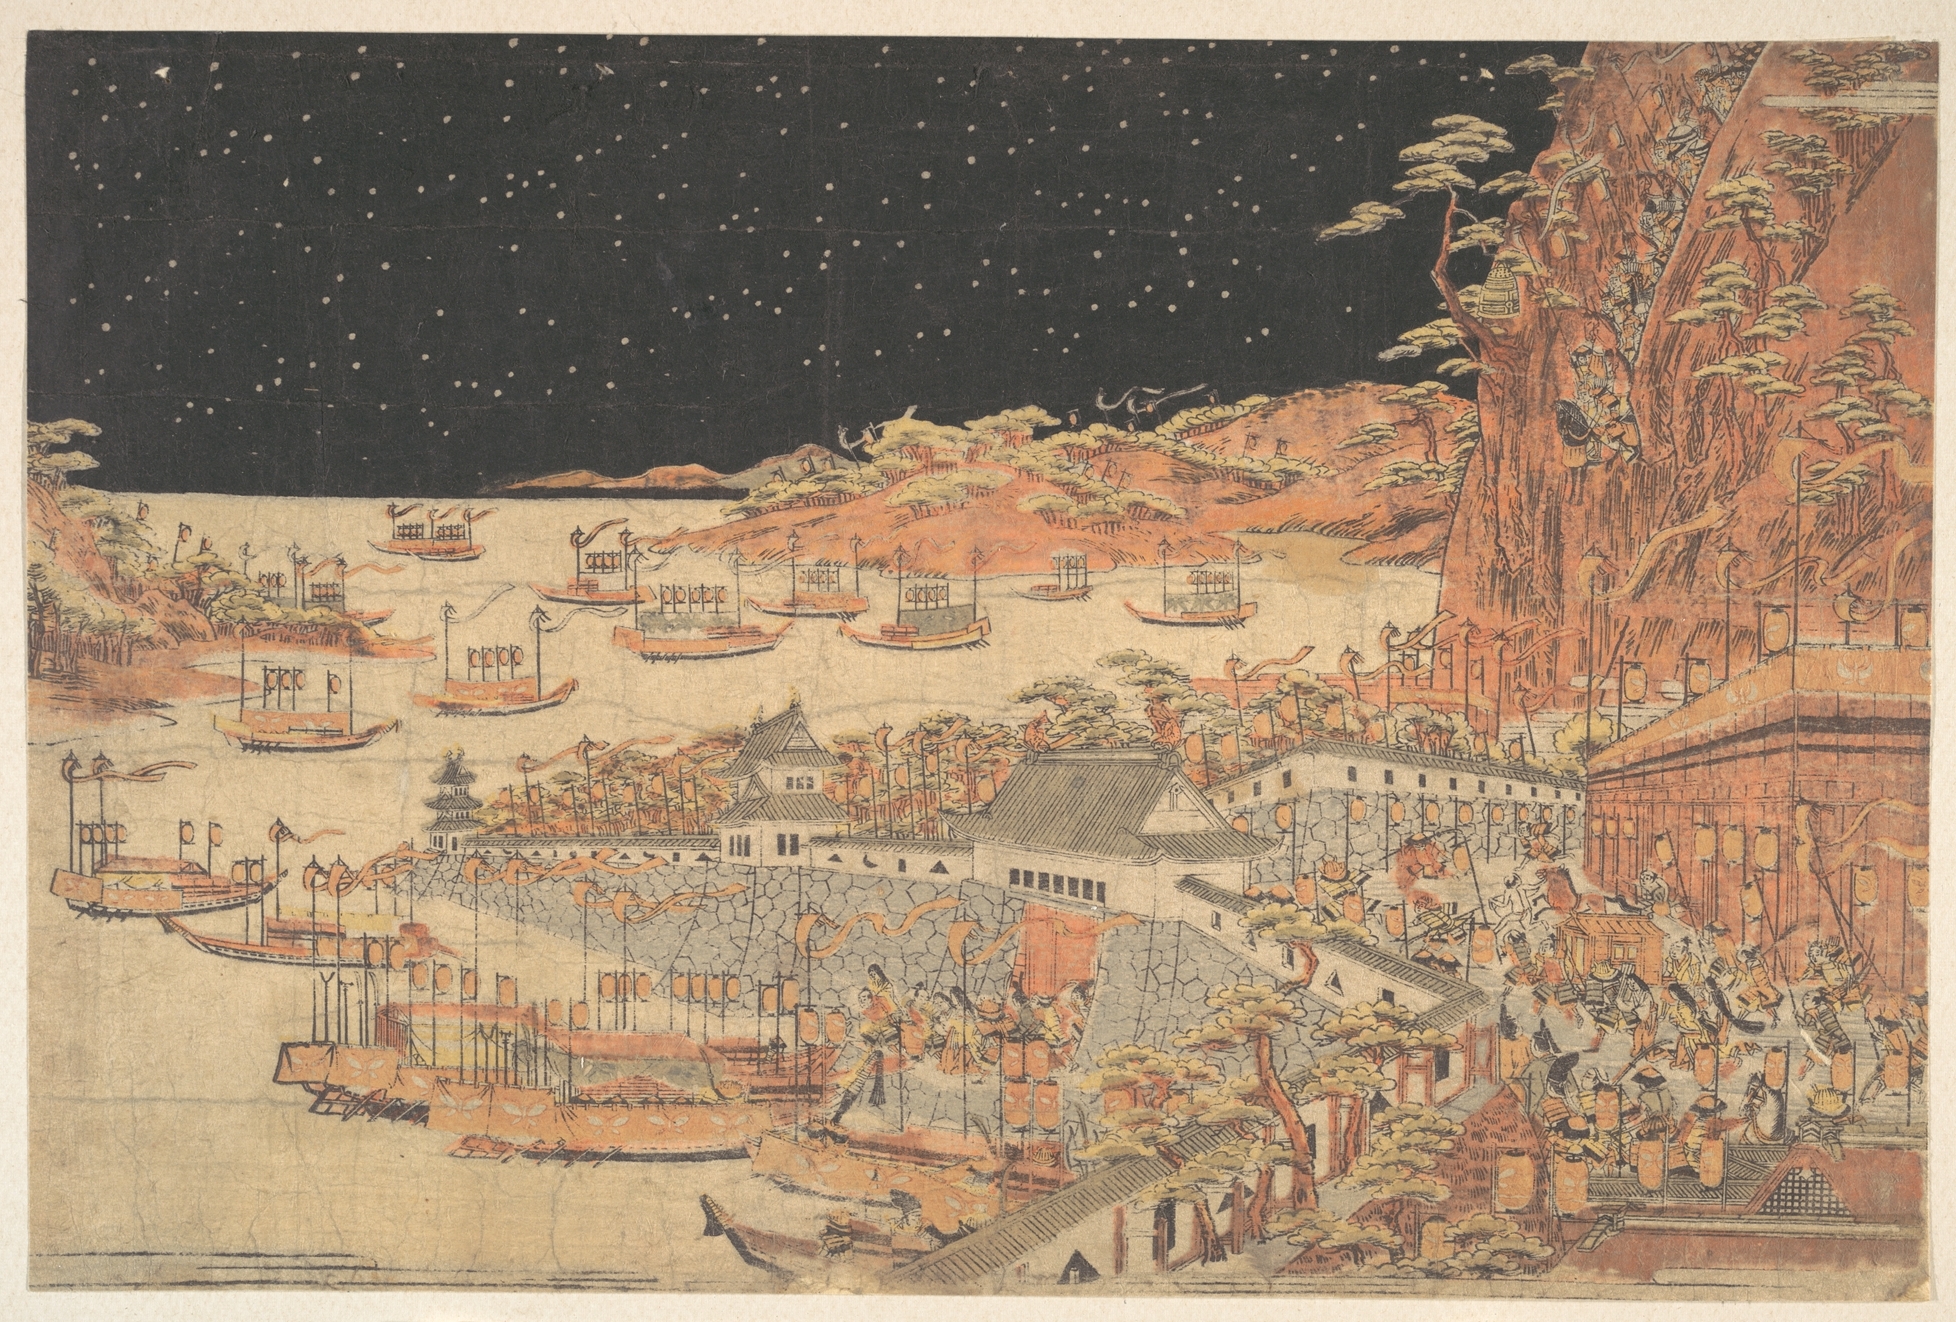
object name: print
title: Battle of Ichi–no–tani, March 21, 1184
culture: japanese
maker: utagawa toyoharu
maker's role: artist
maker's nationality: japanese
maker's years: 1735-1814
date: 1735-1814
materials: ink, paper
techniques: woodblock print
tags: battles,ships